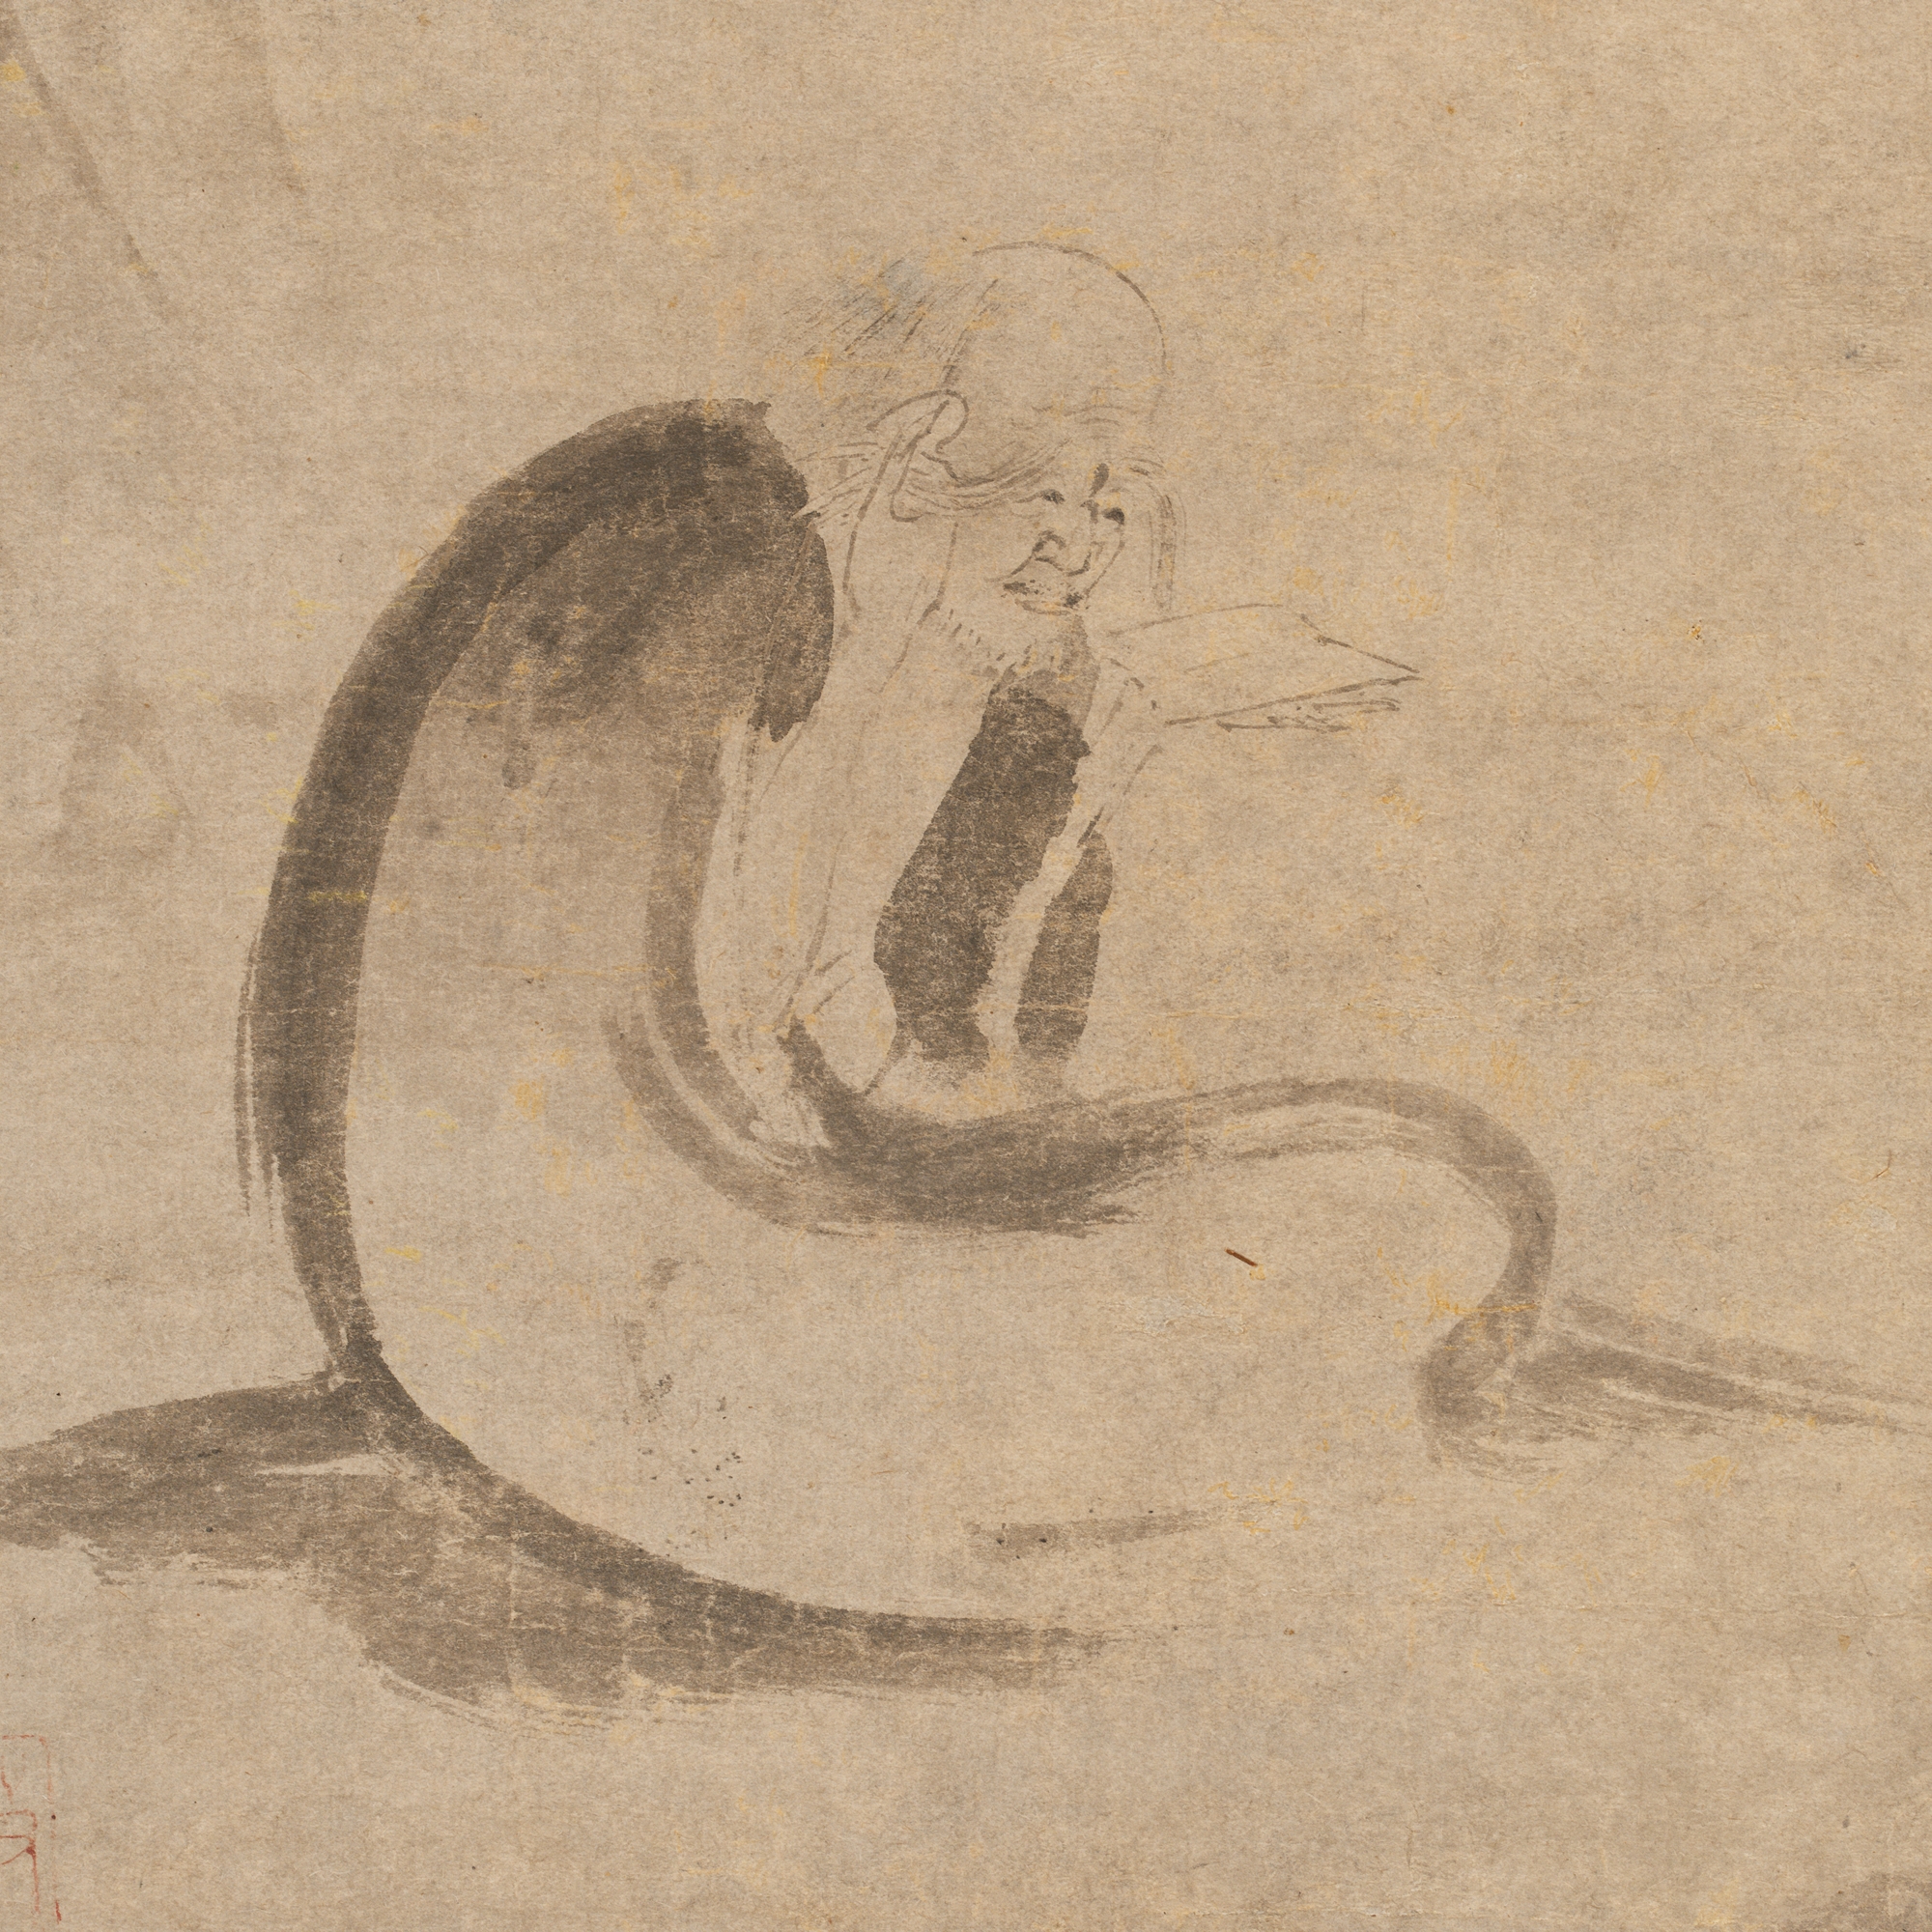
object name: hanging scroll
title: Reading a sutra by moonlight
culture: chinese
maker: unidentified artist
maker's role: artist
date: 1332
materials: ink, paper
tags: men,reading